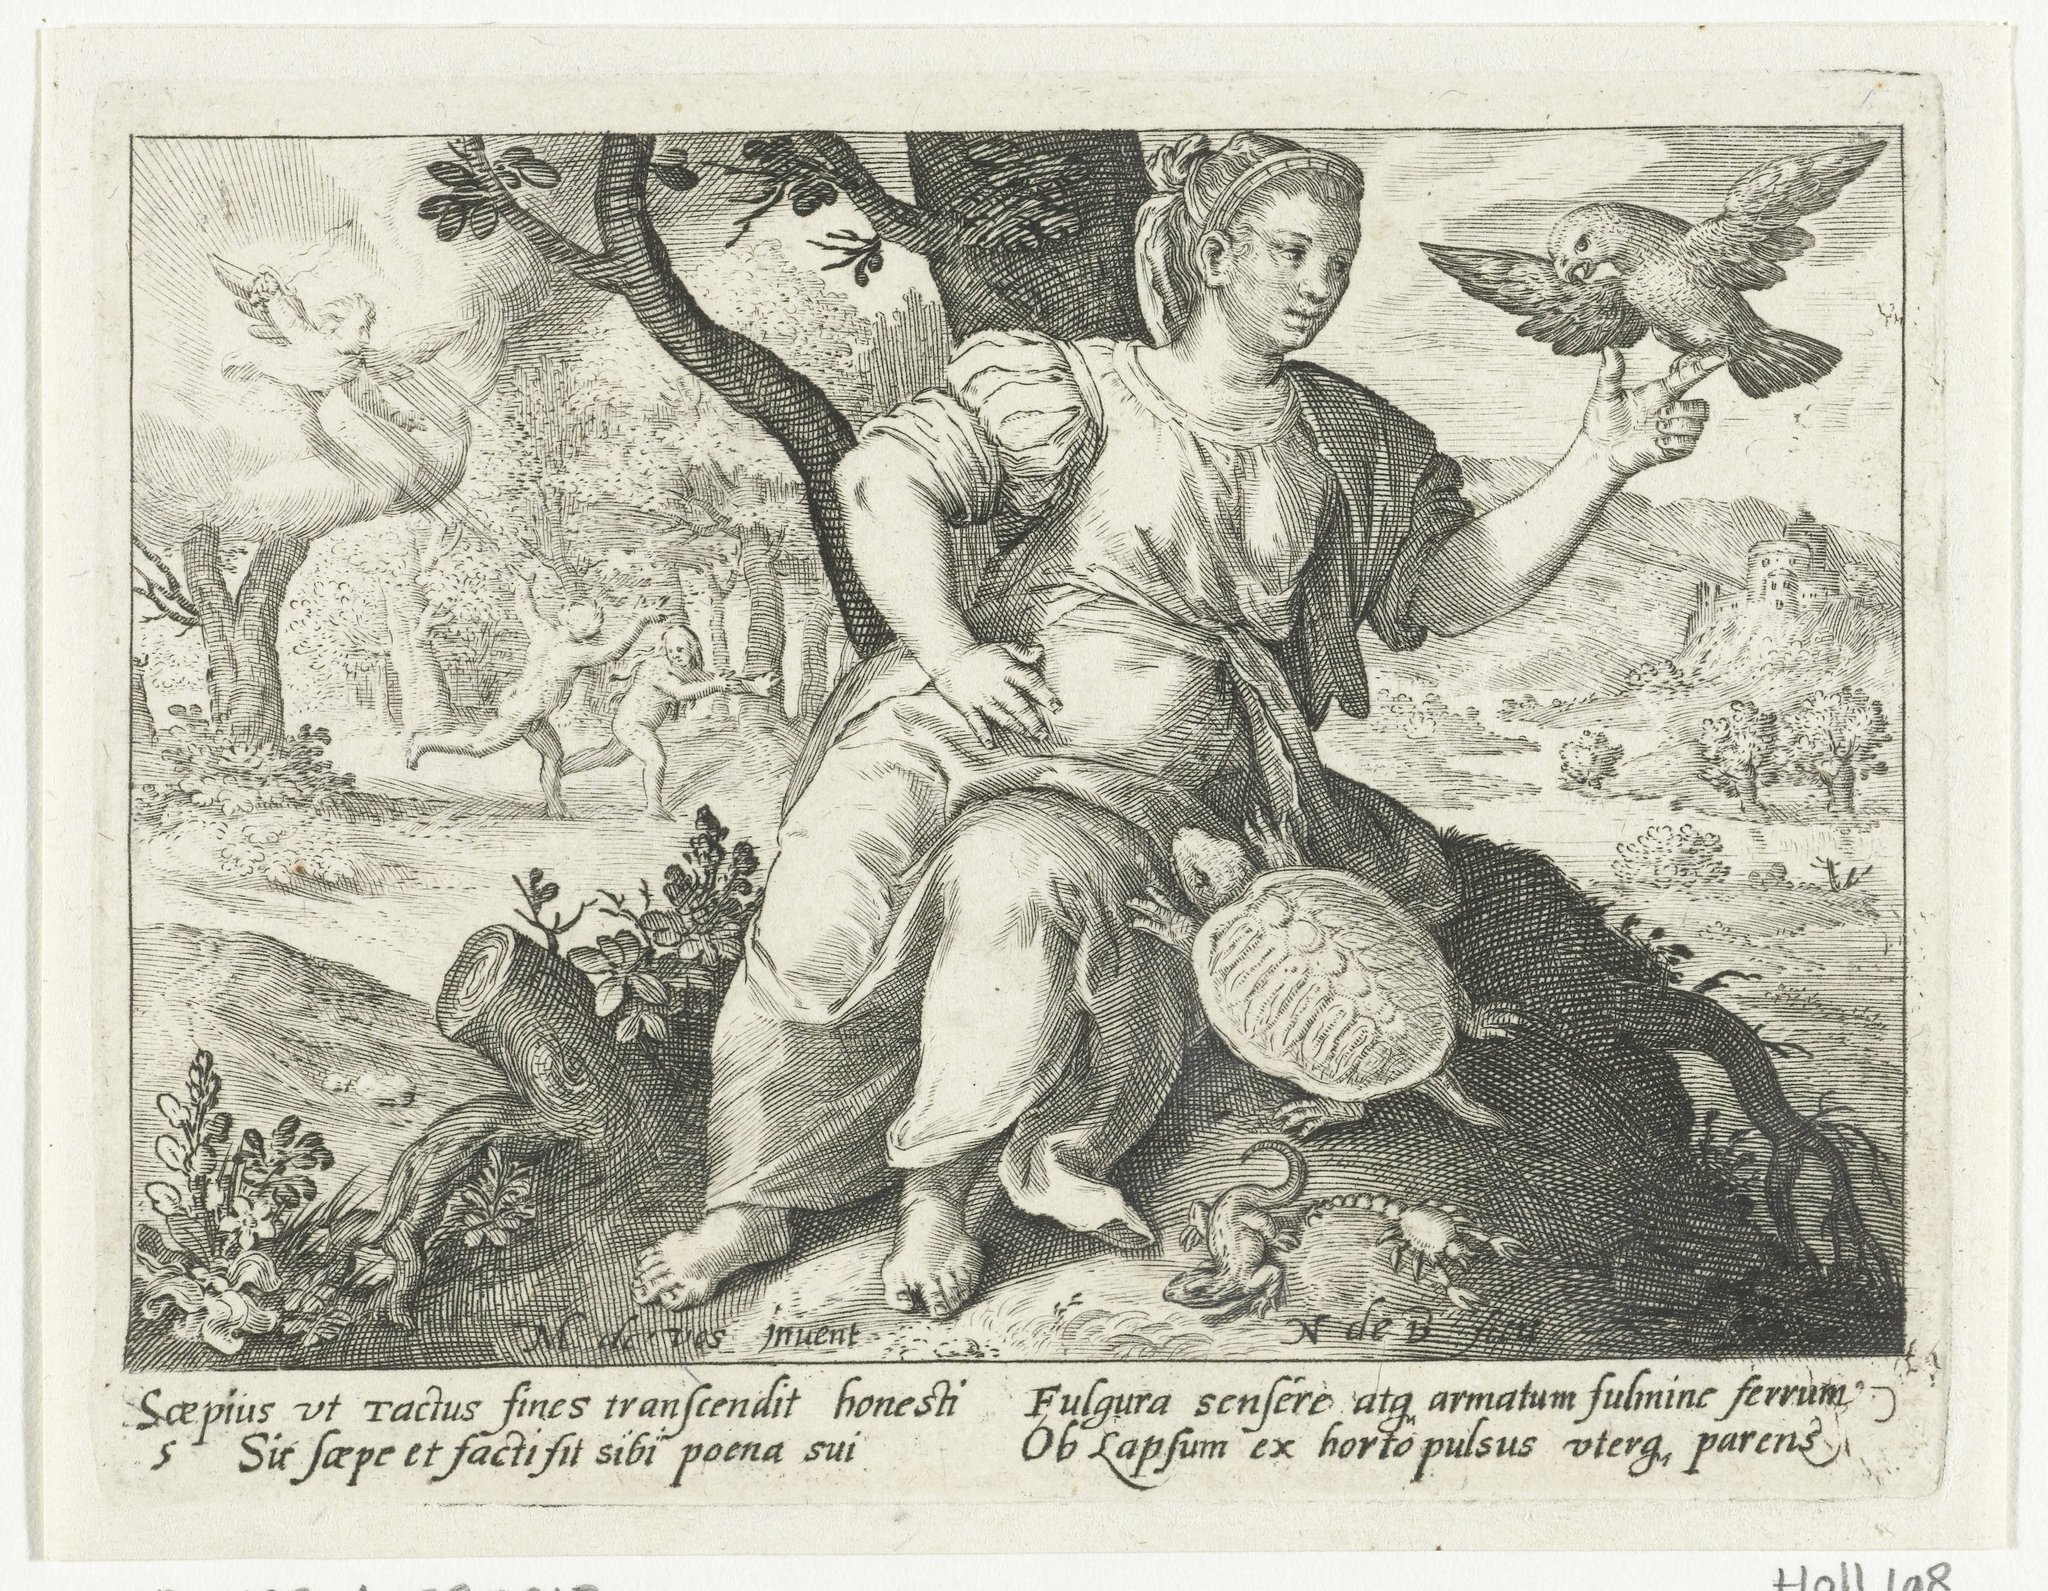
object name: print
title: Vijf zintuigen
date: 1581-1656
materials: paper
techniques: engraving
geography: netherlands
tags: tortoises, turtles, ornamental birds: parrot, expulsion of adam and eve from paradise (genesis 3:22-24), feeling (one of the five senses)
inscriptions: collector's mark: Lugt 2228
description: Vrouw als personificatie van zintuig gevoel zittend in landschap met papegaai op haar hand en schildpad op de grond. Op de achtergrond is de verdrijving van Adam en Eva uit het paradijs weergegeven. In marge onder twee regels Latijn.